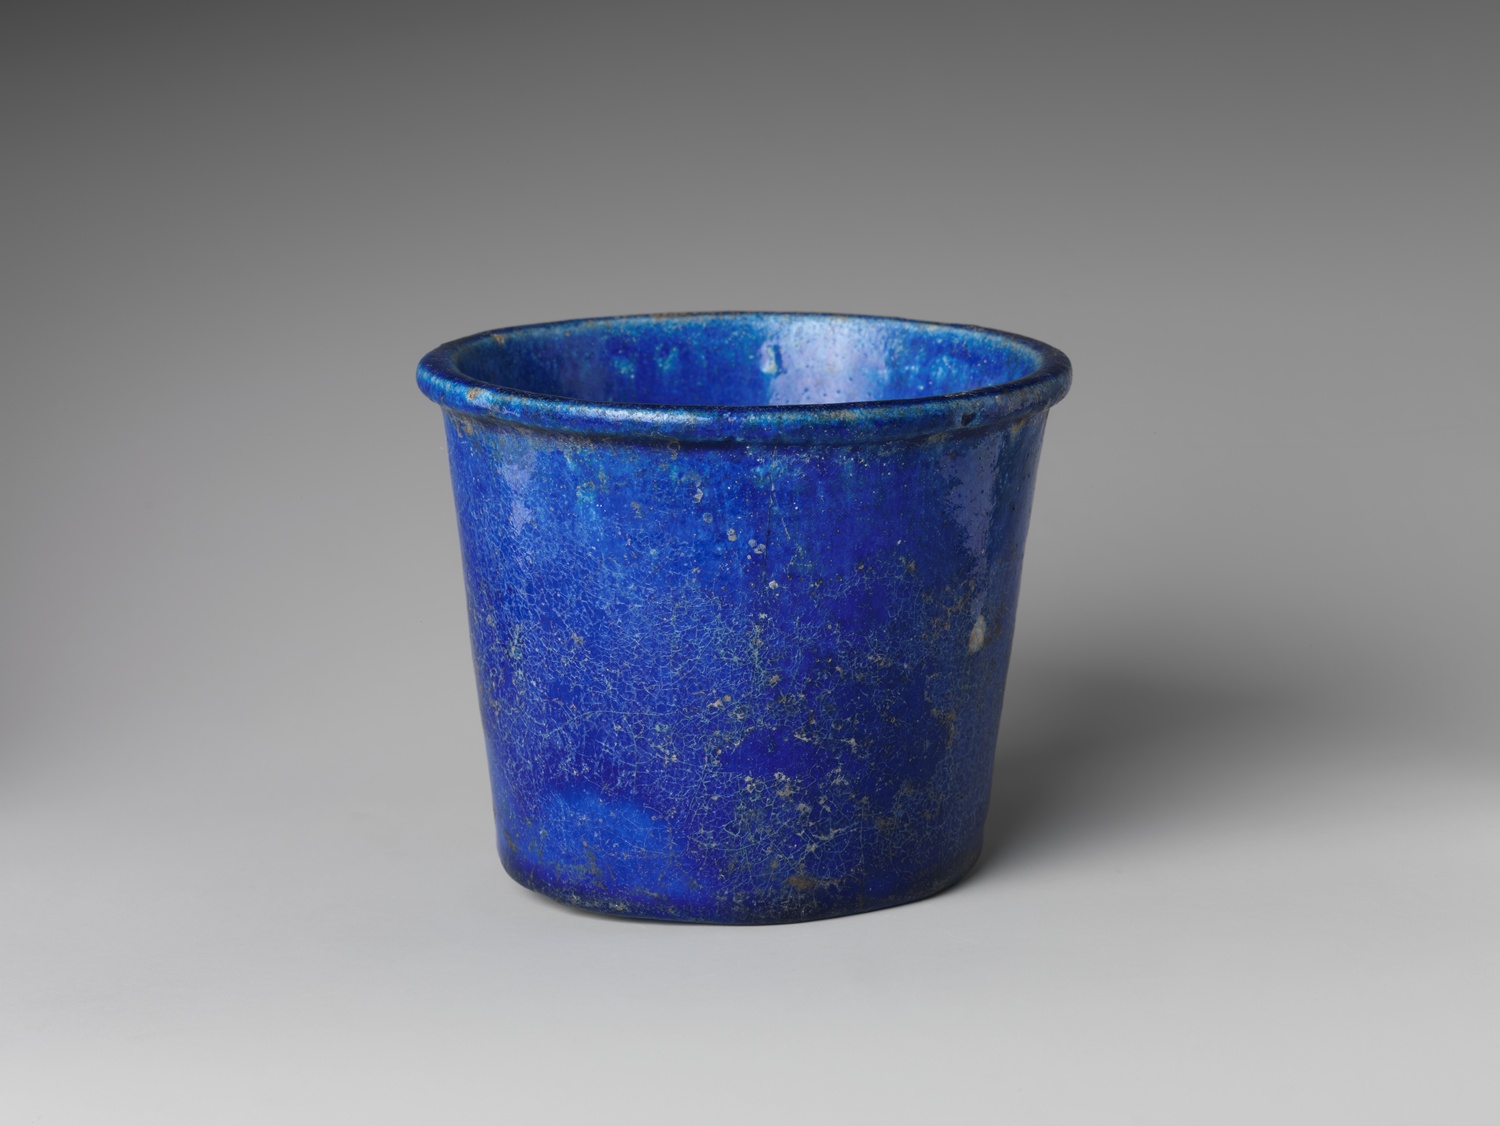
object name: cup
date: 500-200 BCE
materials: faience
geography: egypt